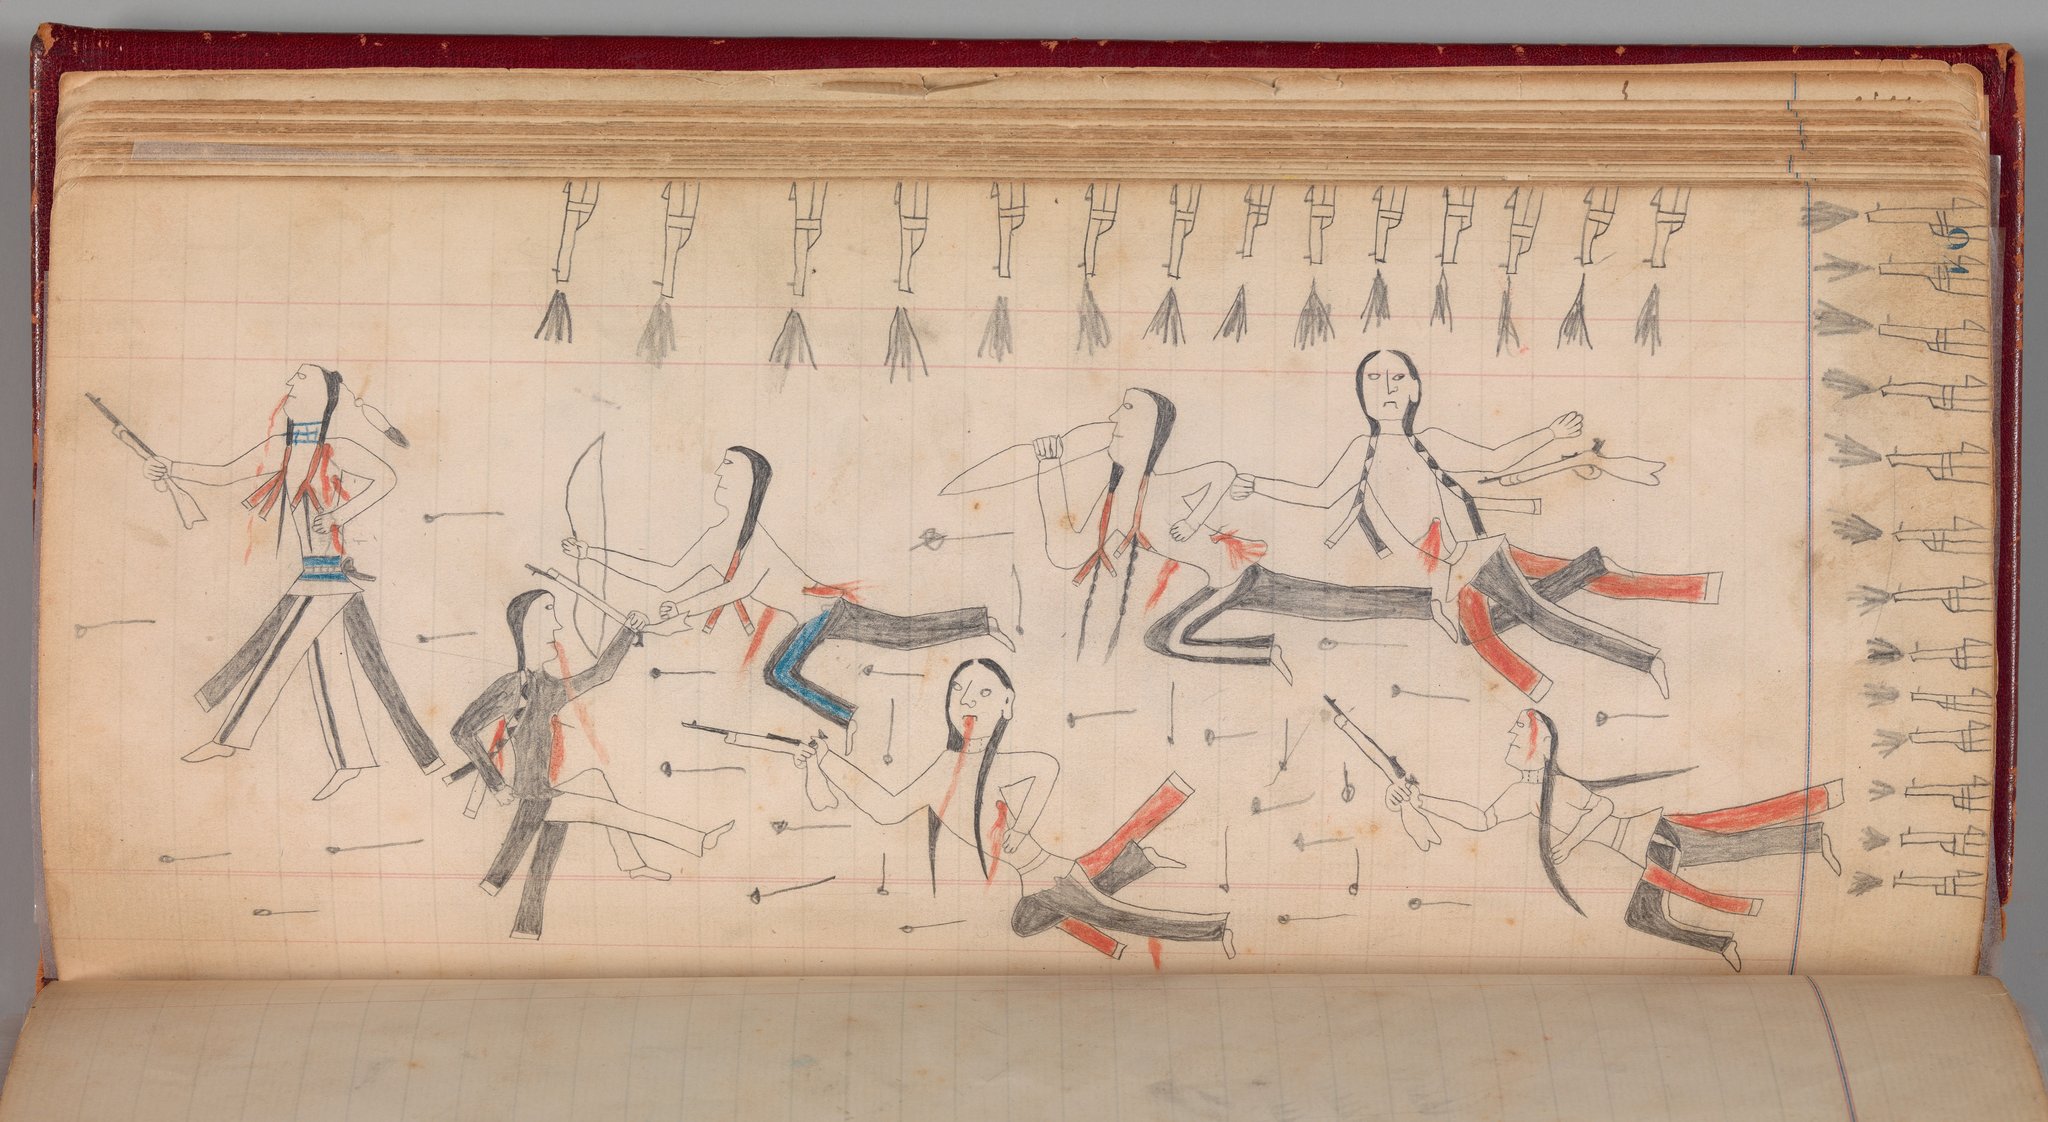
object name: drawing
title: Maffet Ledger: Drawing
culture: cheyenne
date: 1874-1881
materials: crayon, graphite, paper, watercolor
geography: united states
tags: bow and arrow,firearms